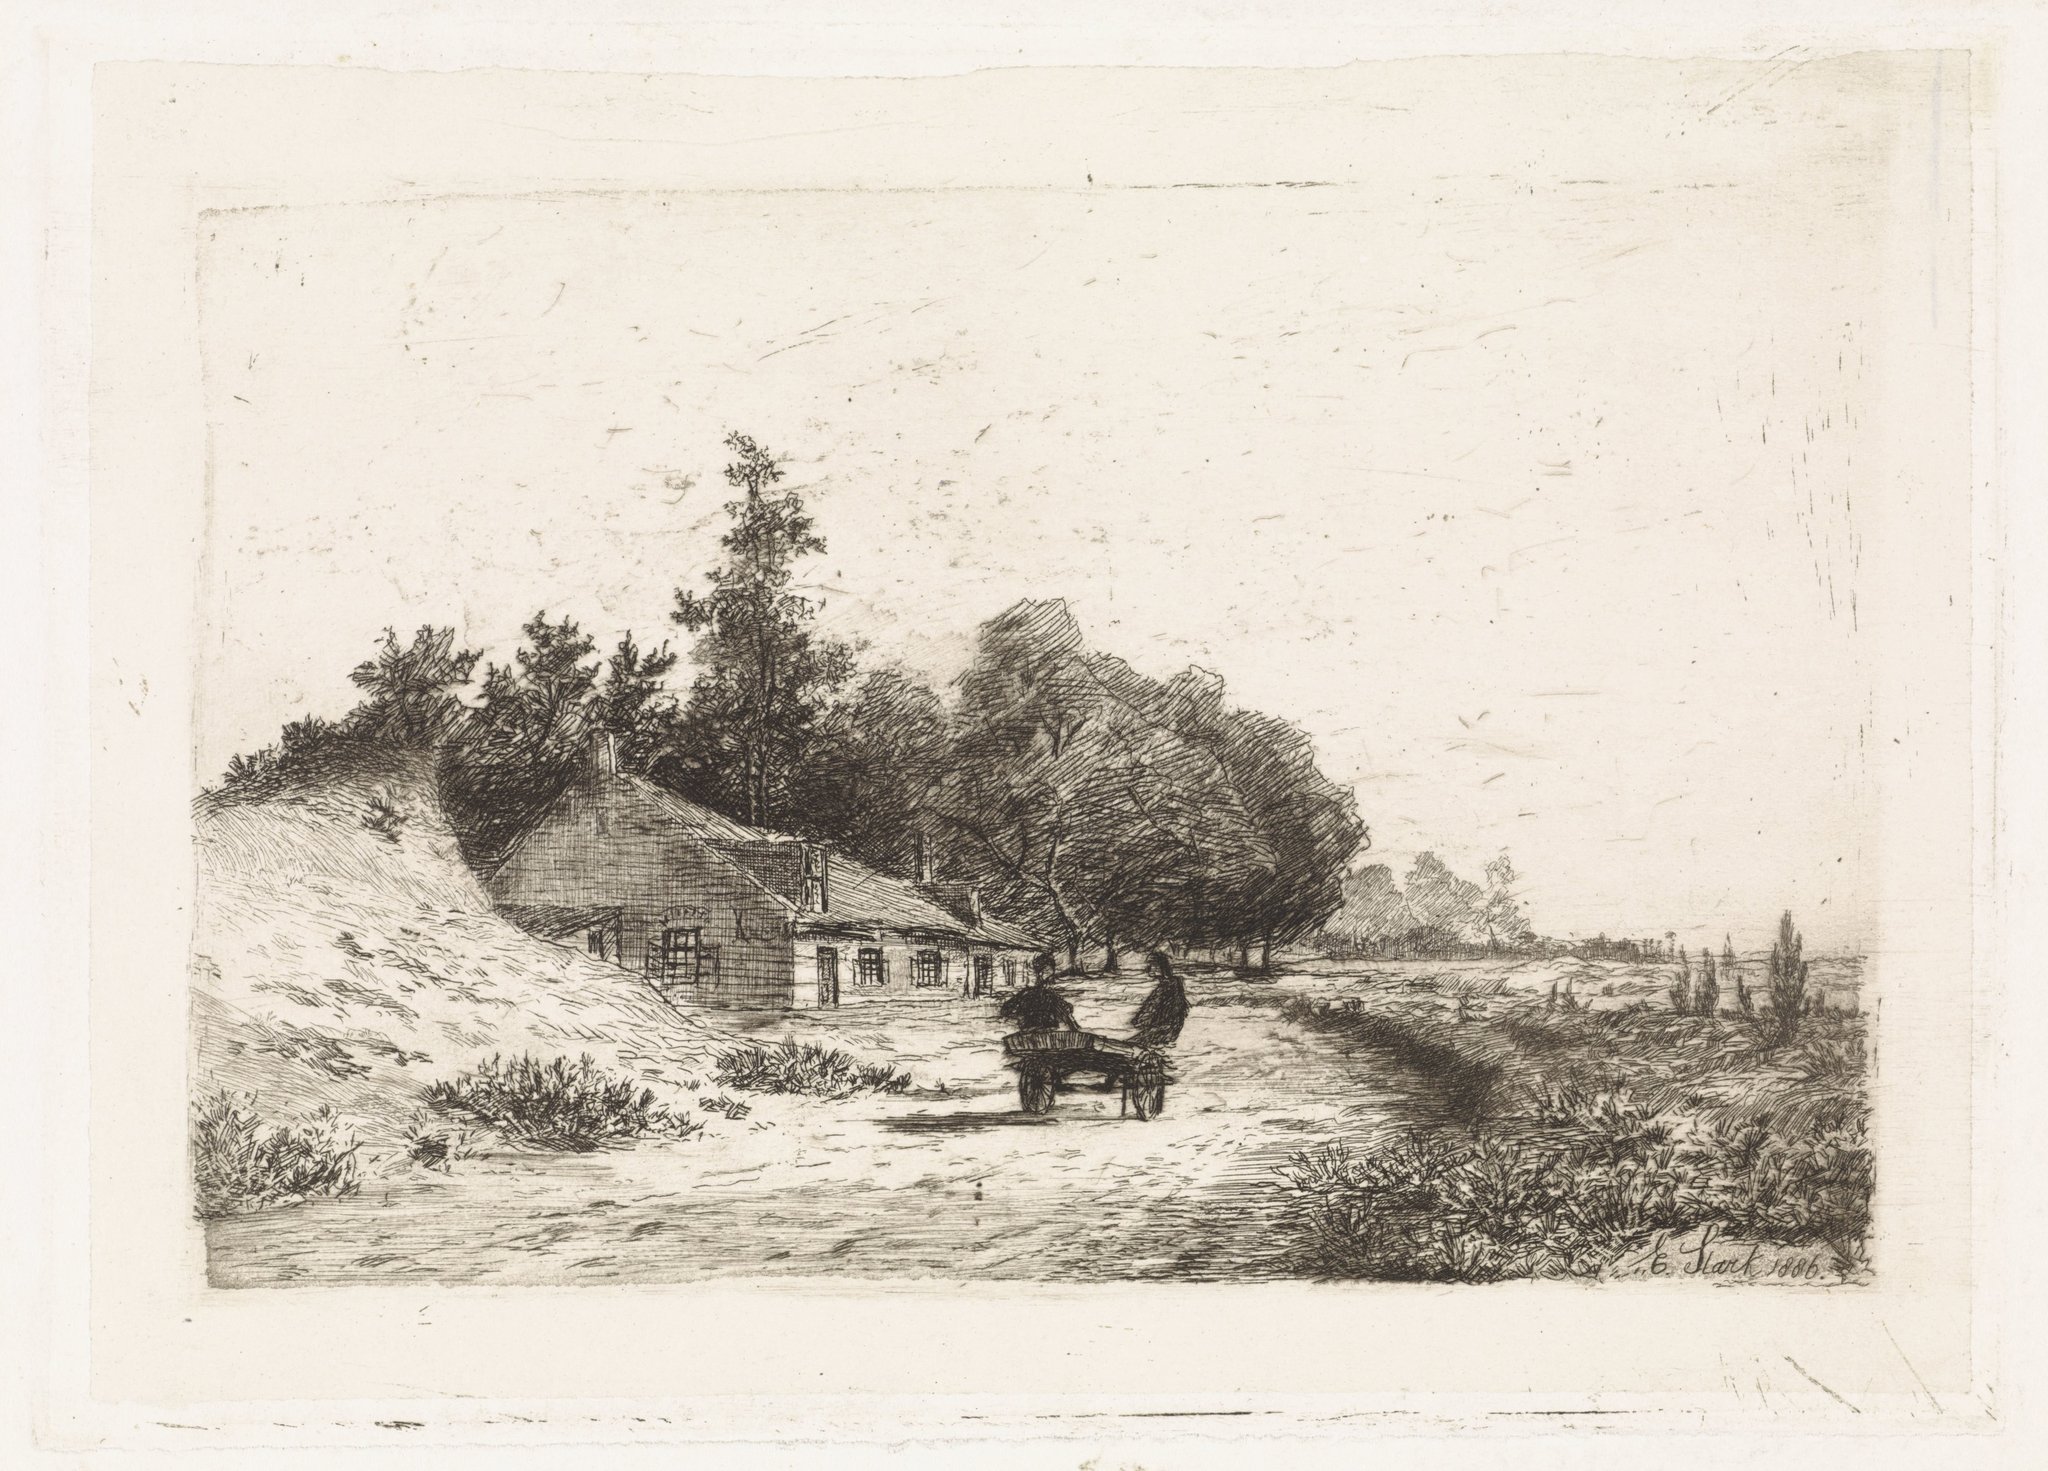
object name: print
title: De Bilt bij Utrecht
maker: elias stark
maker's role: draughtsman, print maker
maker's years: 1849-1933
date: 1886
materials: paper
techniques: aquatint, drypoint, etching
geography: nieuwer-amstel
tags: farm or solitary house in landscape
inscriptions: collector's mark: Lugt 2228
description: Twee mannen rijden op een kar langs een woning in De Bilt.